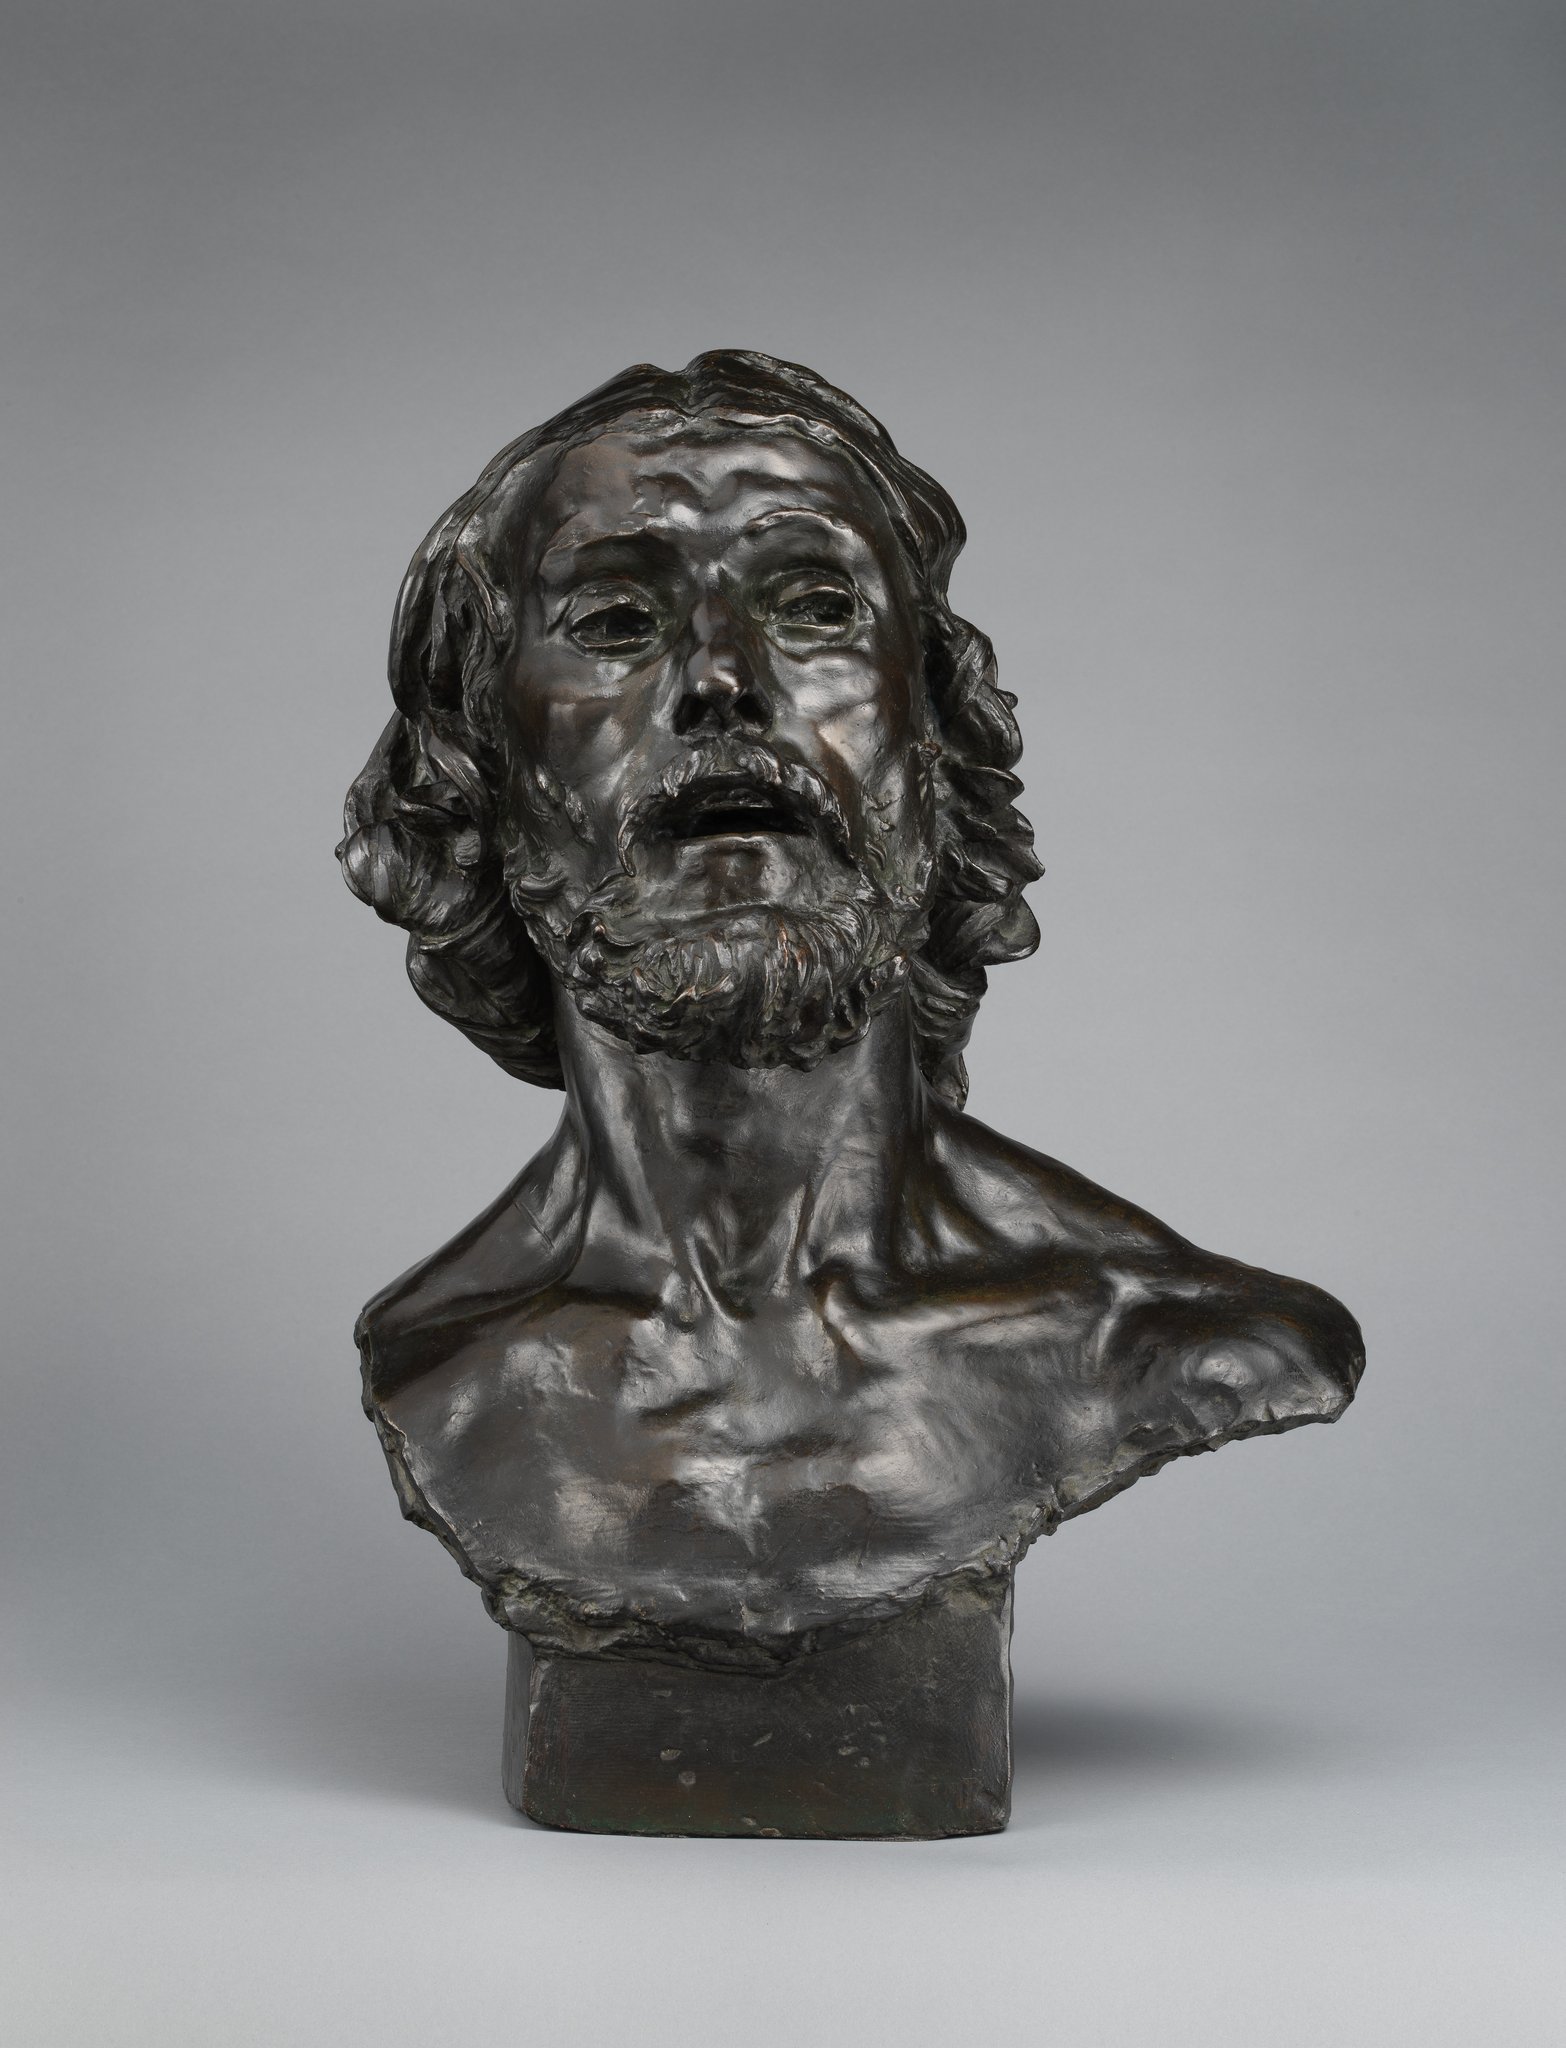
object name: bust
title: St. John the Baptist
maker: auguste rodin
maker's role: artist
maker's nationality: french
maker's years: 1840-1917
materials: bronze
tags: men,saint john the baptist